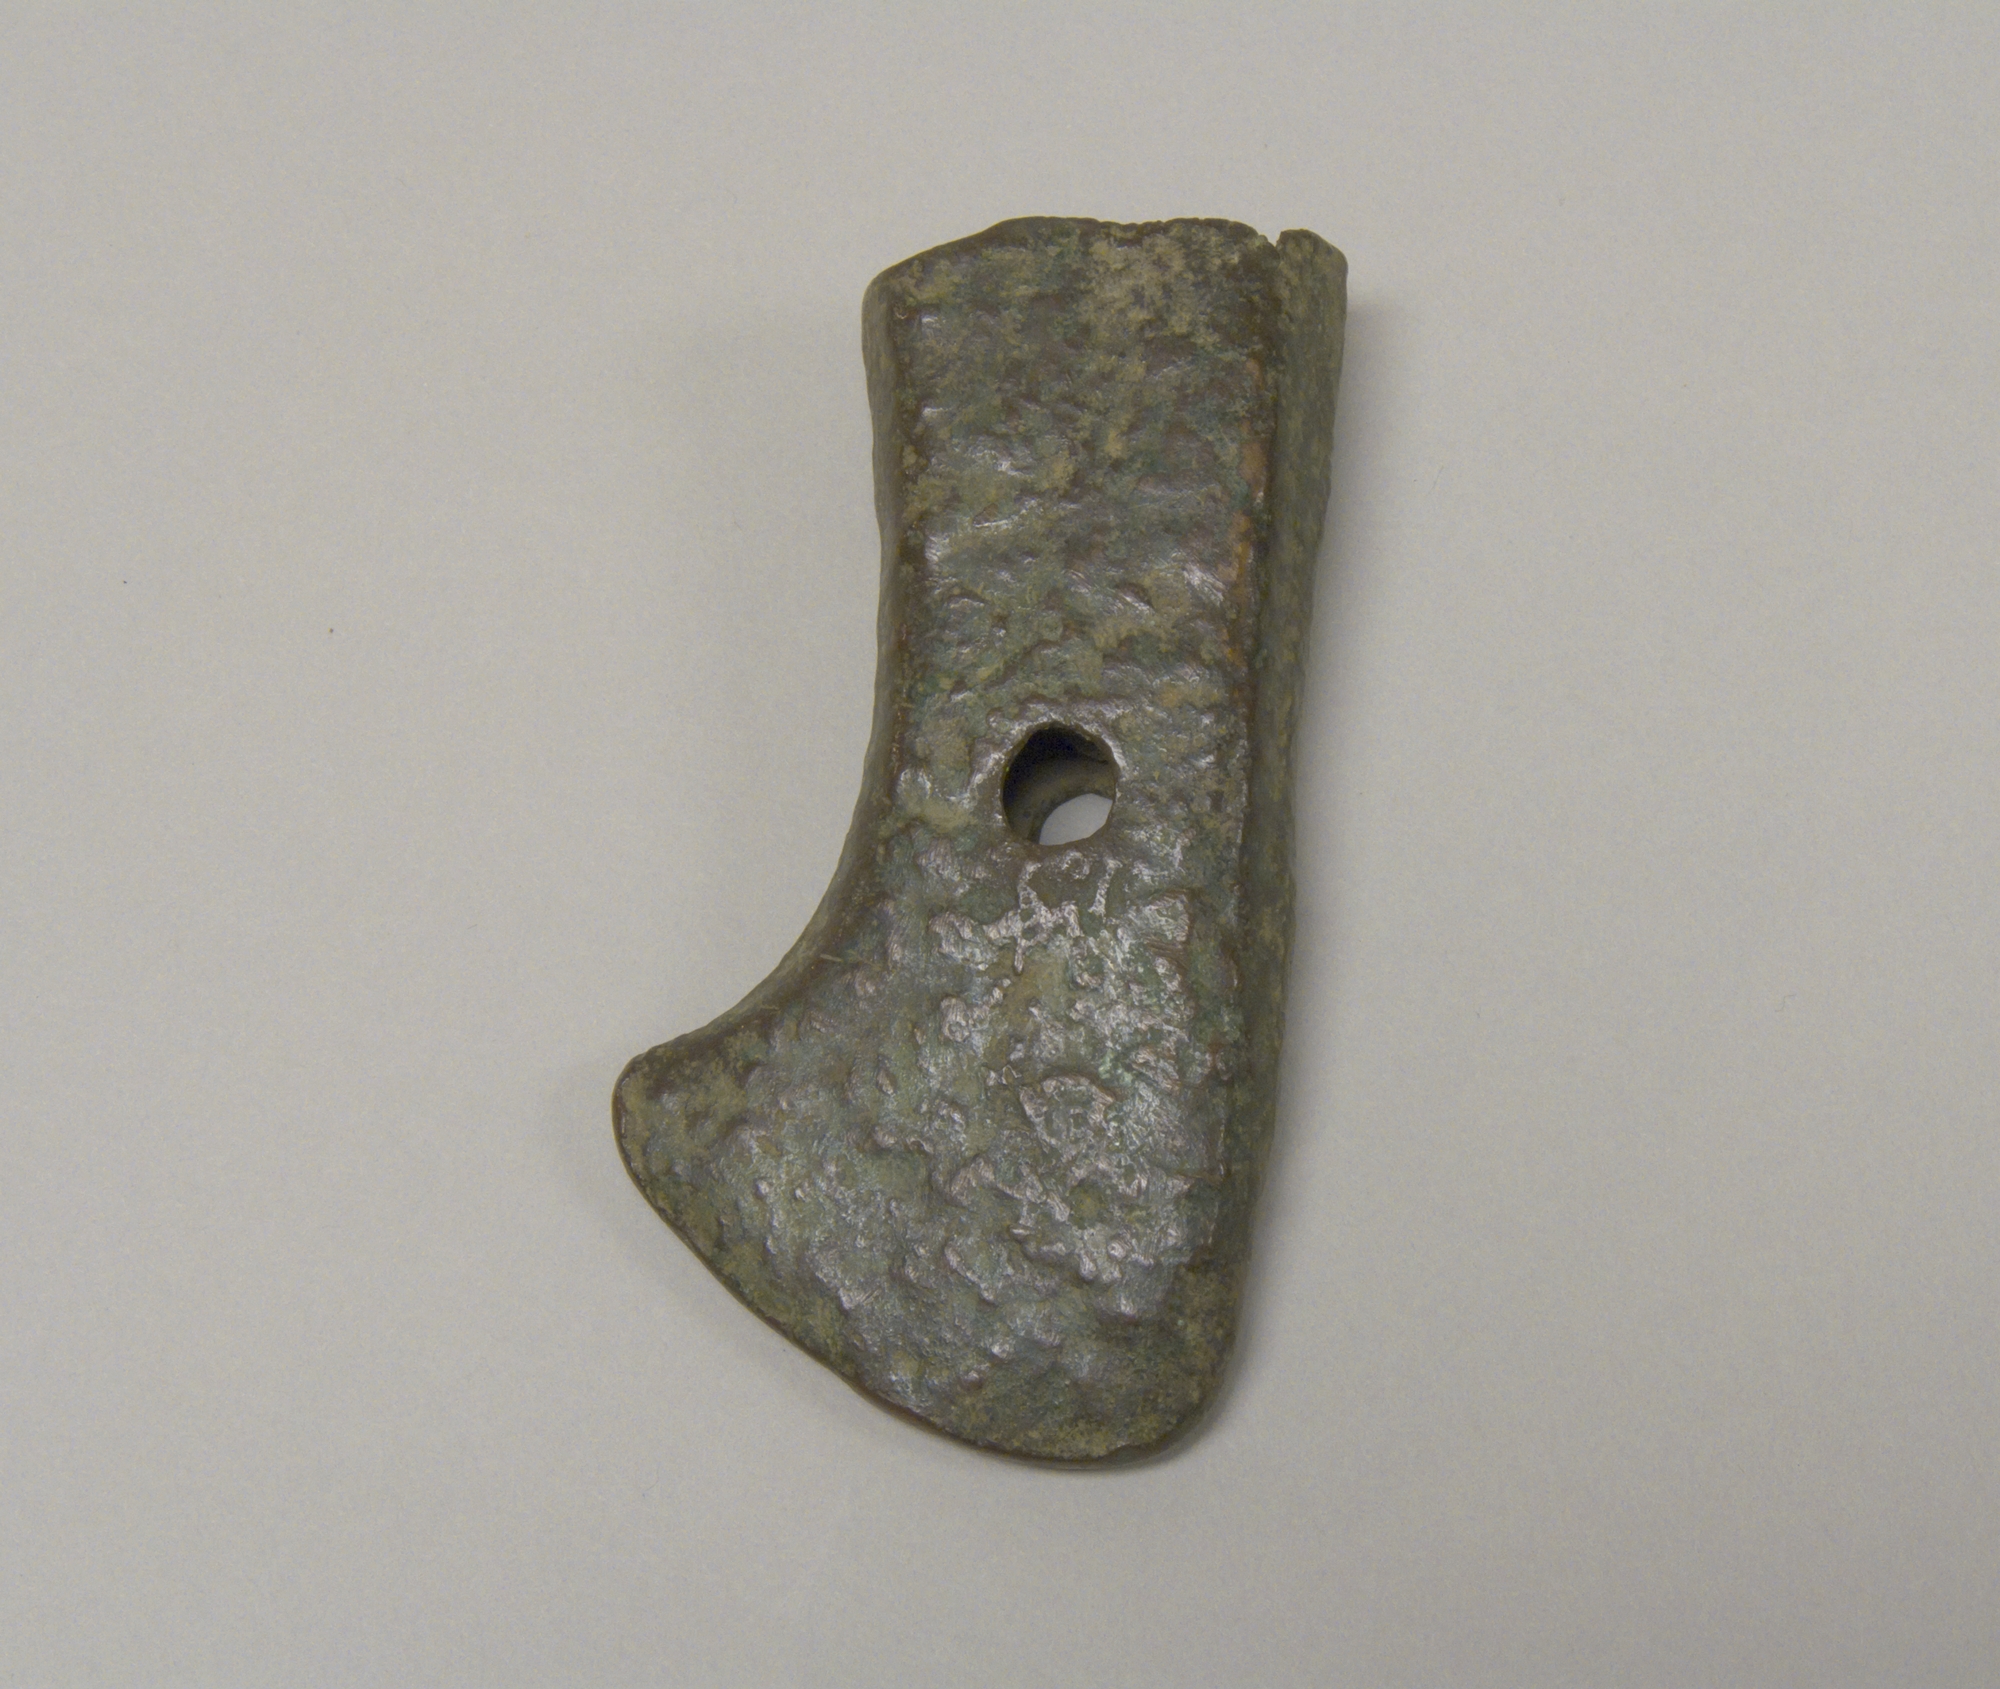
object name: hafted ax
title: Asymmetric Pediform Hafted Ax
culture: vietnamese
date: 500 BCE-300 CE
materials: bronze